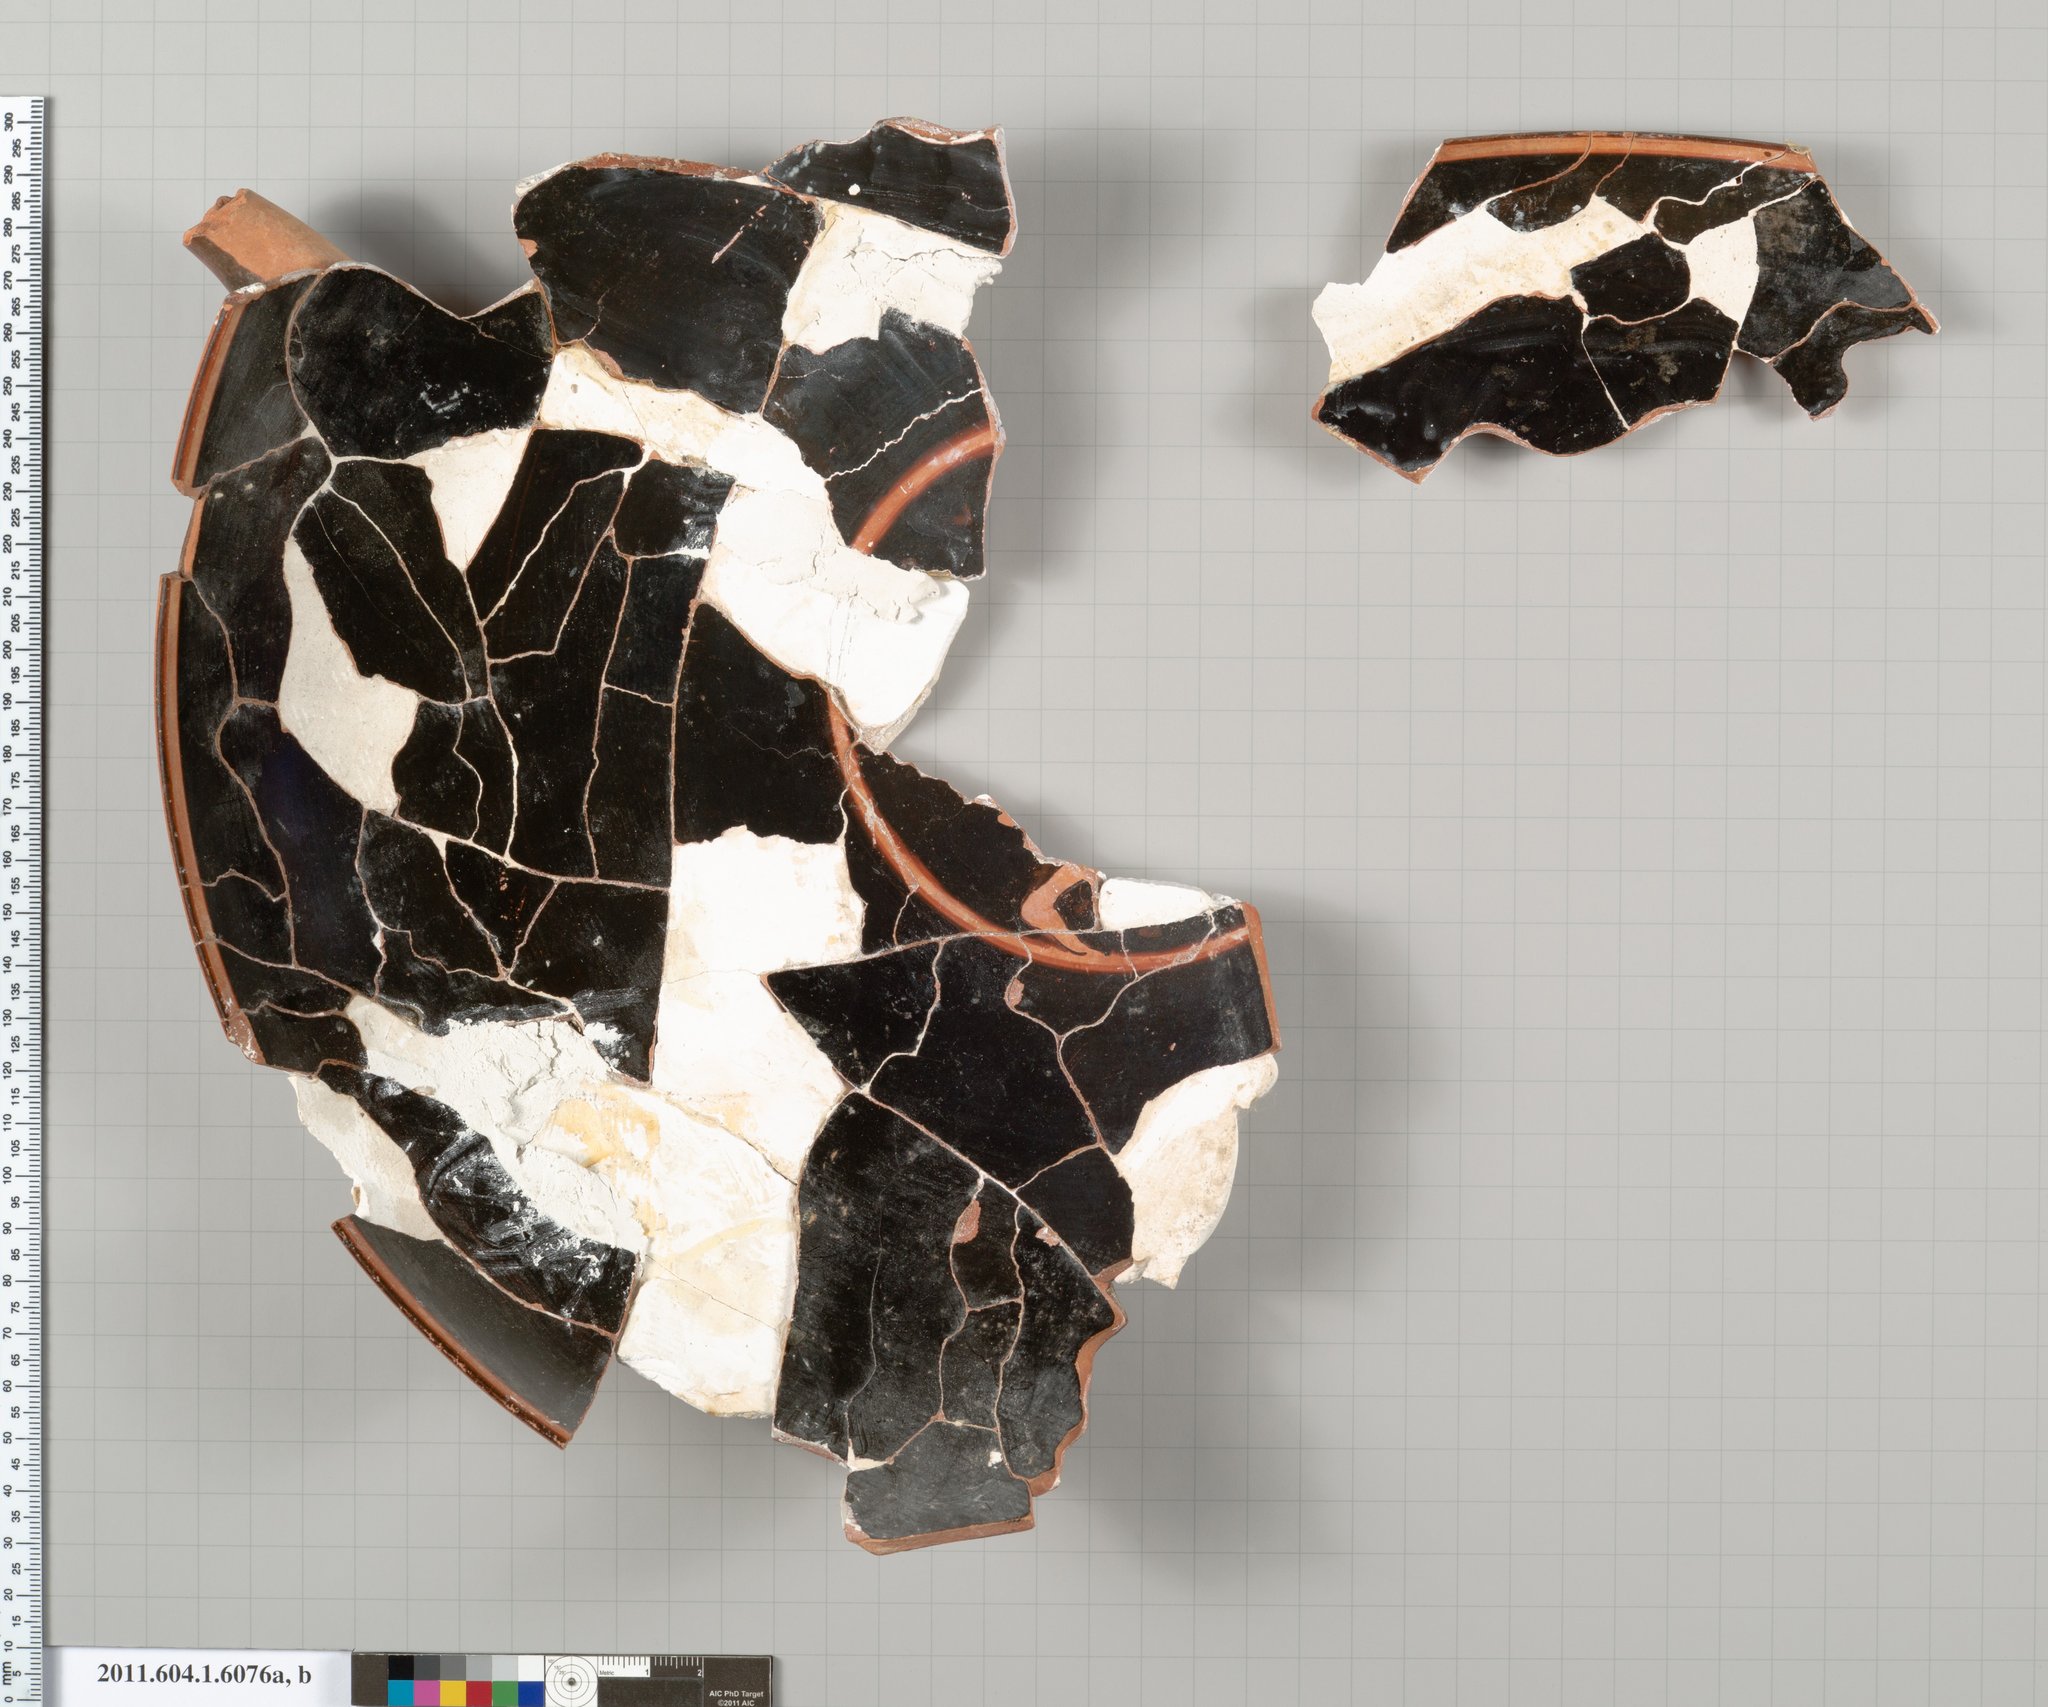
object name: kylix fragment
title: Terracotta fragments of a kylix (drinking cup)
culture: greek, attic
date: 510-500 BCE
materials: terracotta